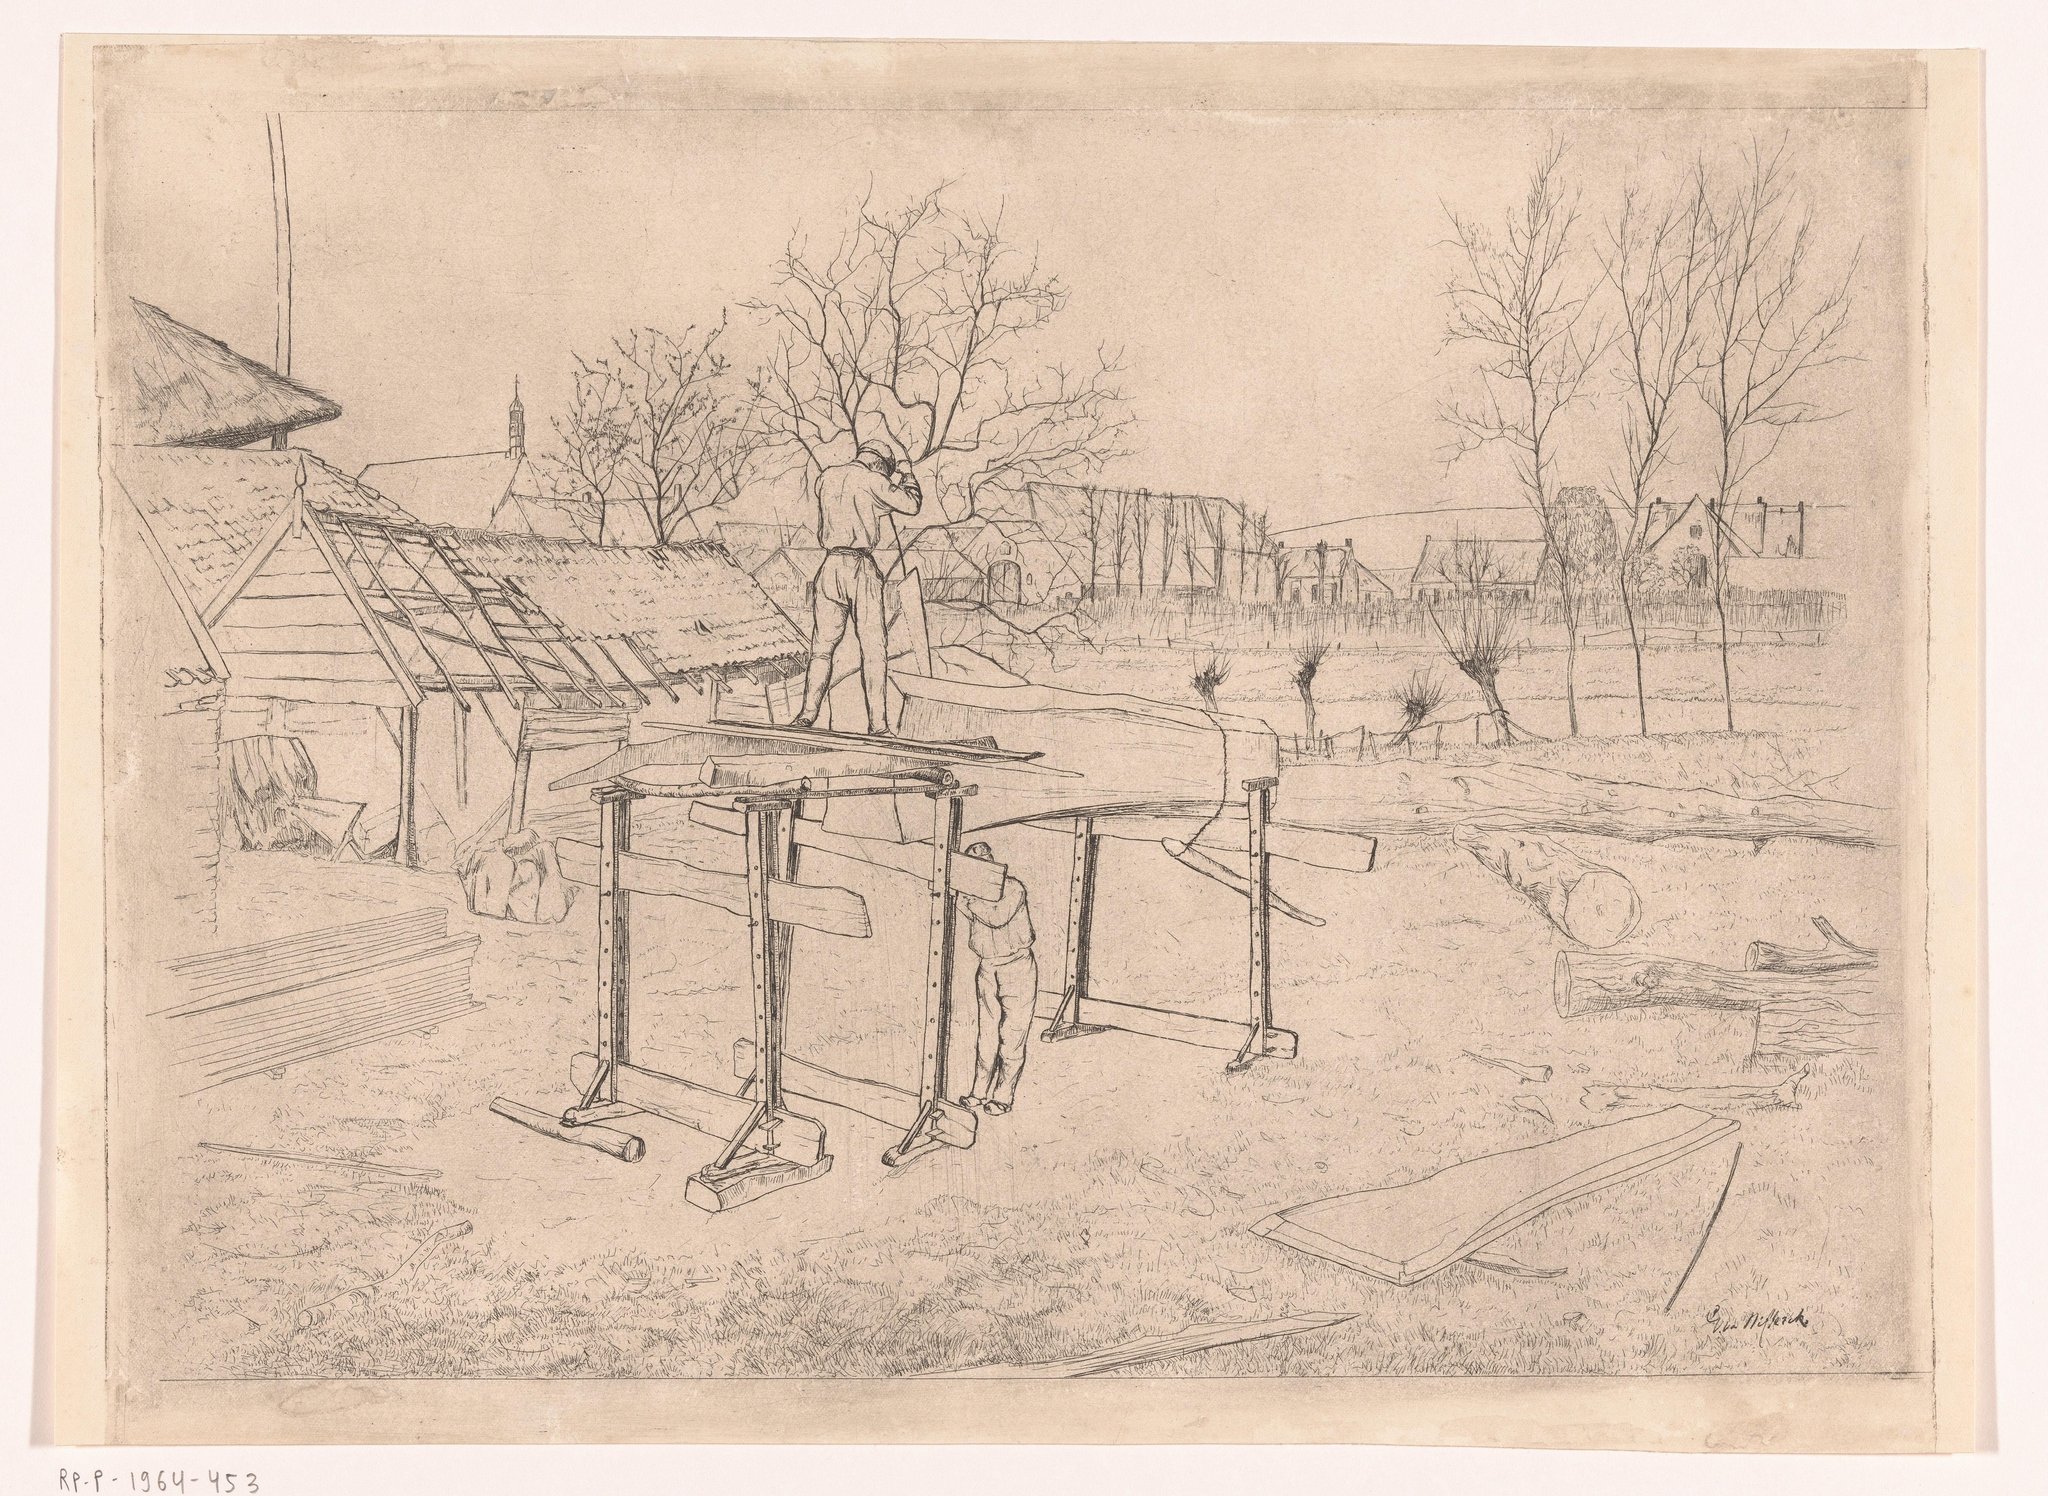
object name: print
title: Twee mannen aan het werk in een houtzagerij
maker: gustaaf van nifterik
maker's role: print maker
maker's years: 1886-1954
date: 1896-1954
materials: paper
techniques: etching, intaglio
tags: wood, timber ~ building material, woodcutting, woodcutter ~ forestry, village, tools, aids, implements ~ crafts and industries: saw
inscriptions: collector's mark: Lugt 2228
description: De mannen zagen een boomstam die zich in een houten stellage bevindt. Op de grond liggen boomstammen en planken. Op de achtergrond verschillende gebouwen, waaronder een kerk en een boerderij.